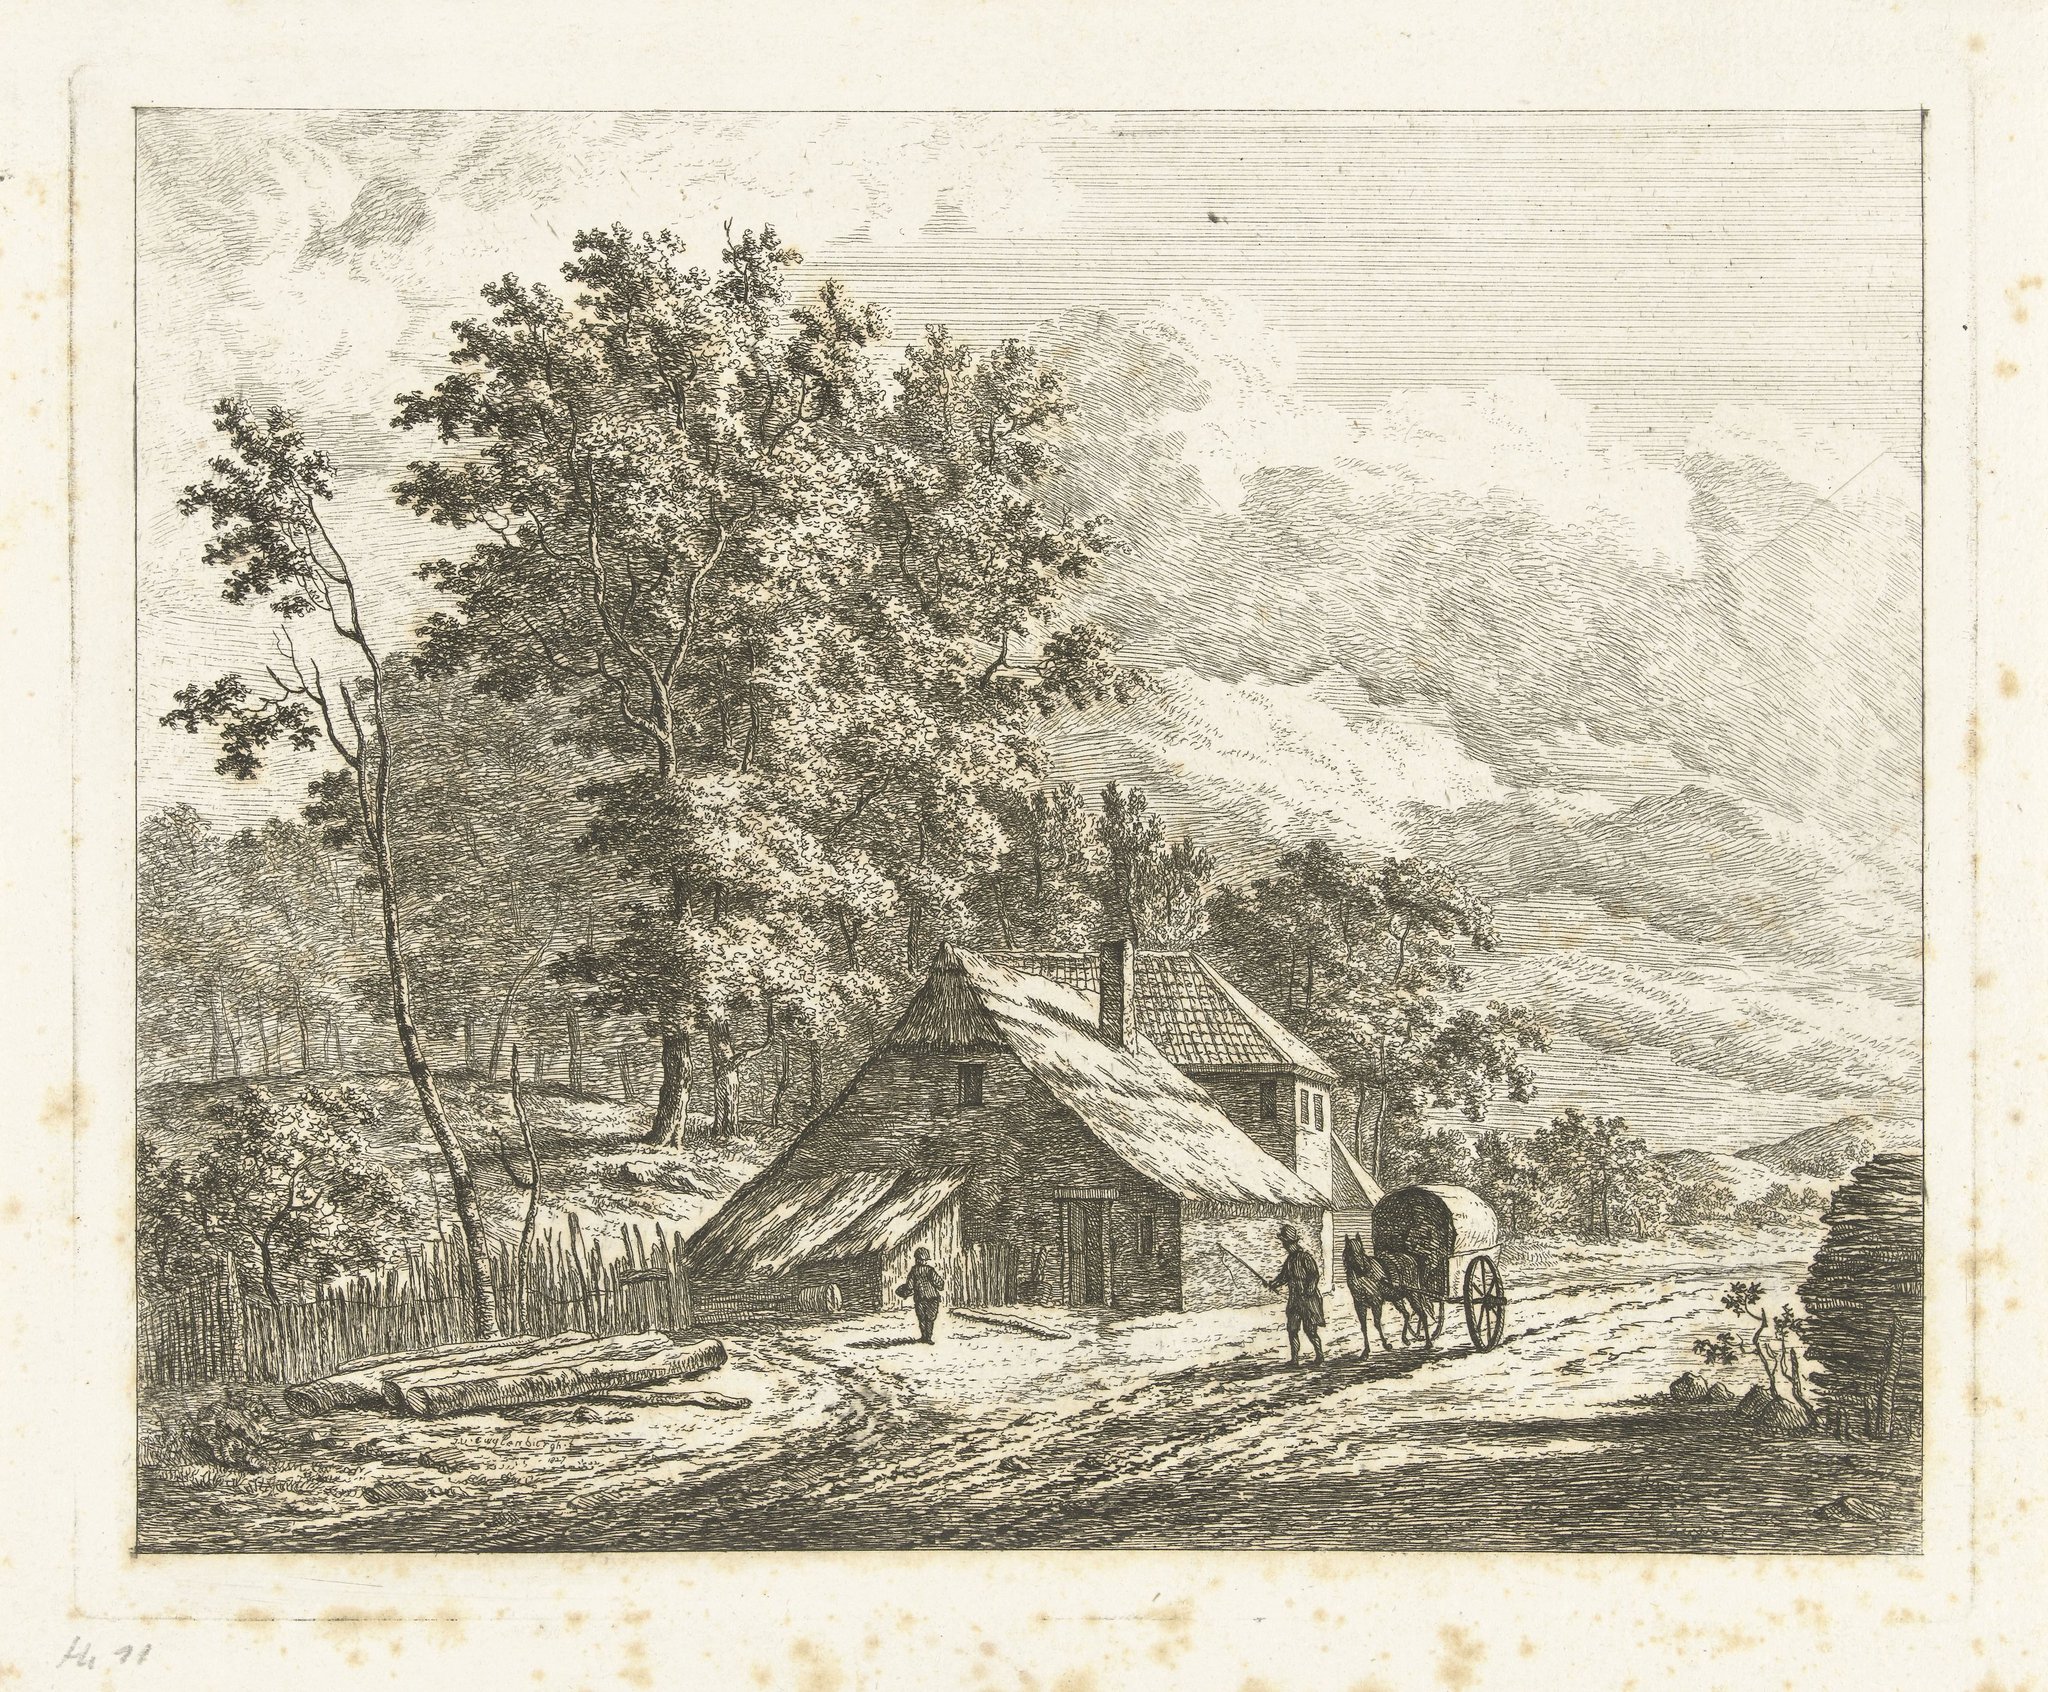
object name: print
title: Landschap met boerderij en paard en wagen op landweg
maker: johannes van cuylenburgh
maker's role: print maker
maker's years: 1793-1841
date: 1827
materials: paper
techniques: etching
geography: netherlands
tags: two-wheeled, animal-drawn vehicle, farm or solitary house in landscape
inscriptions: collector's mark: Lugt 2228, collector's mark: Lugt 1485